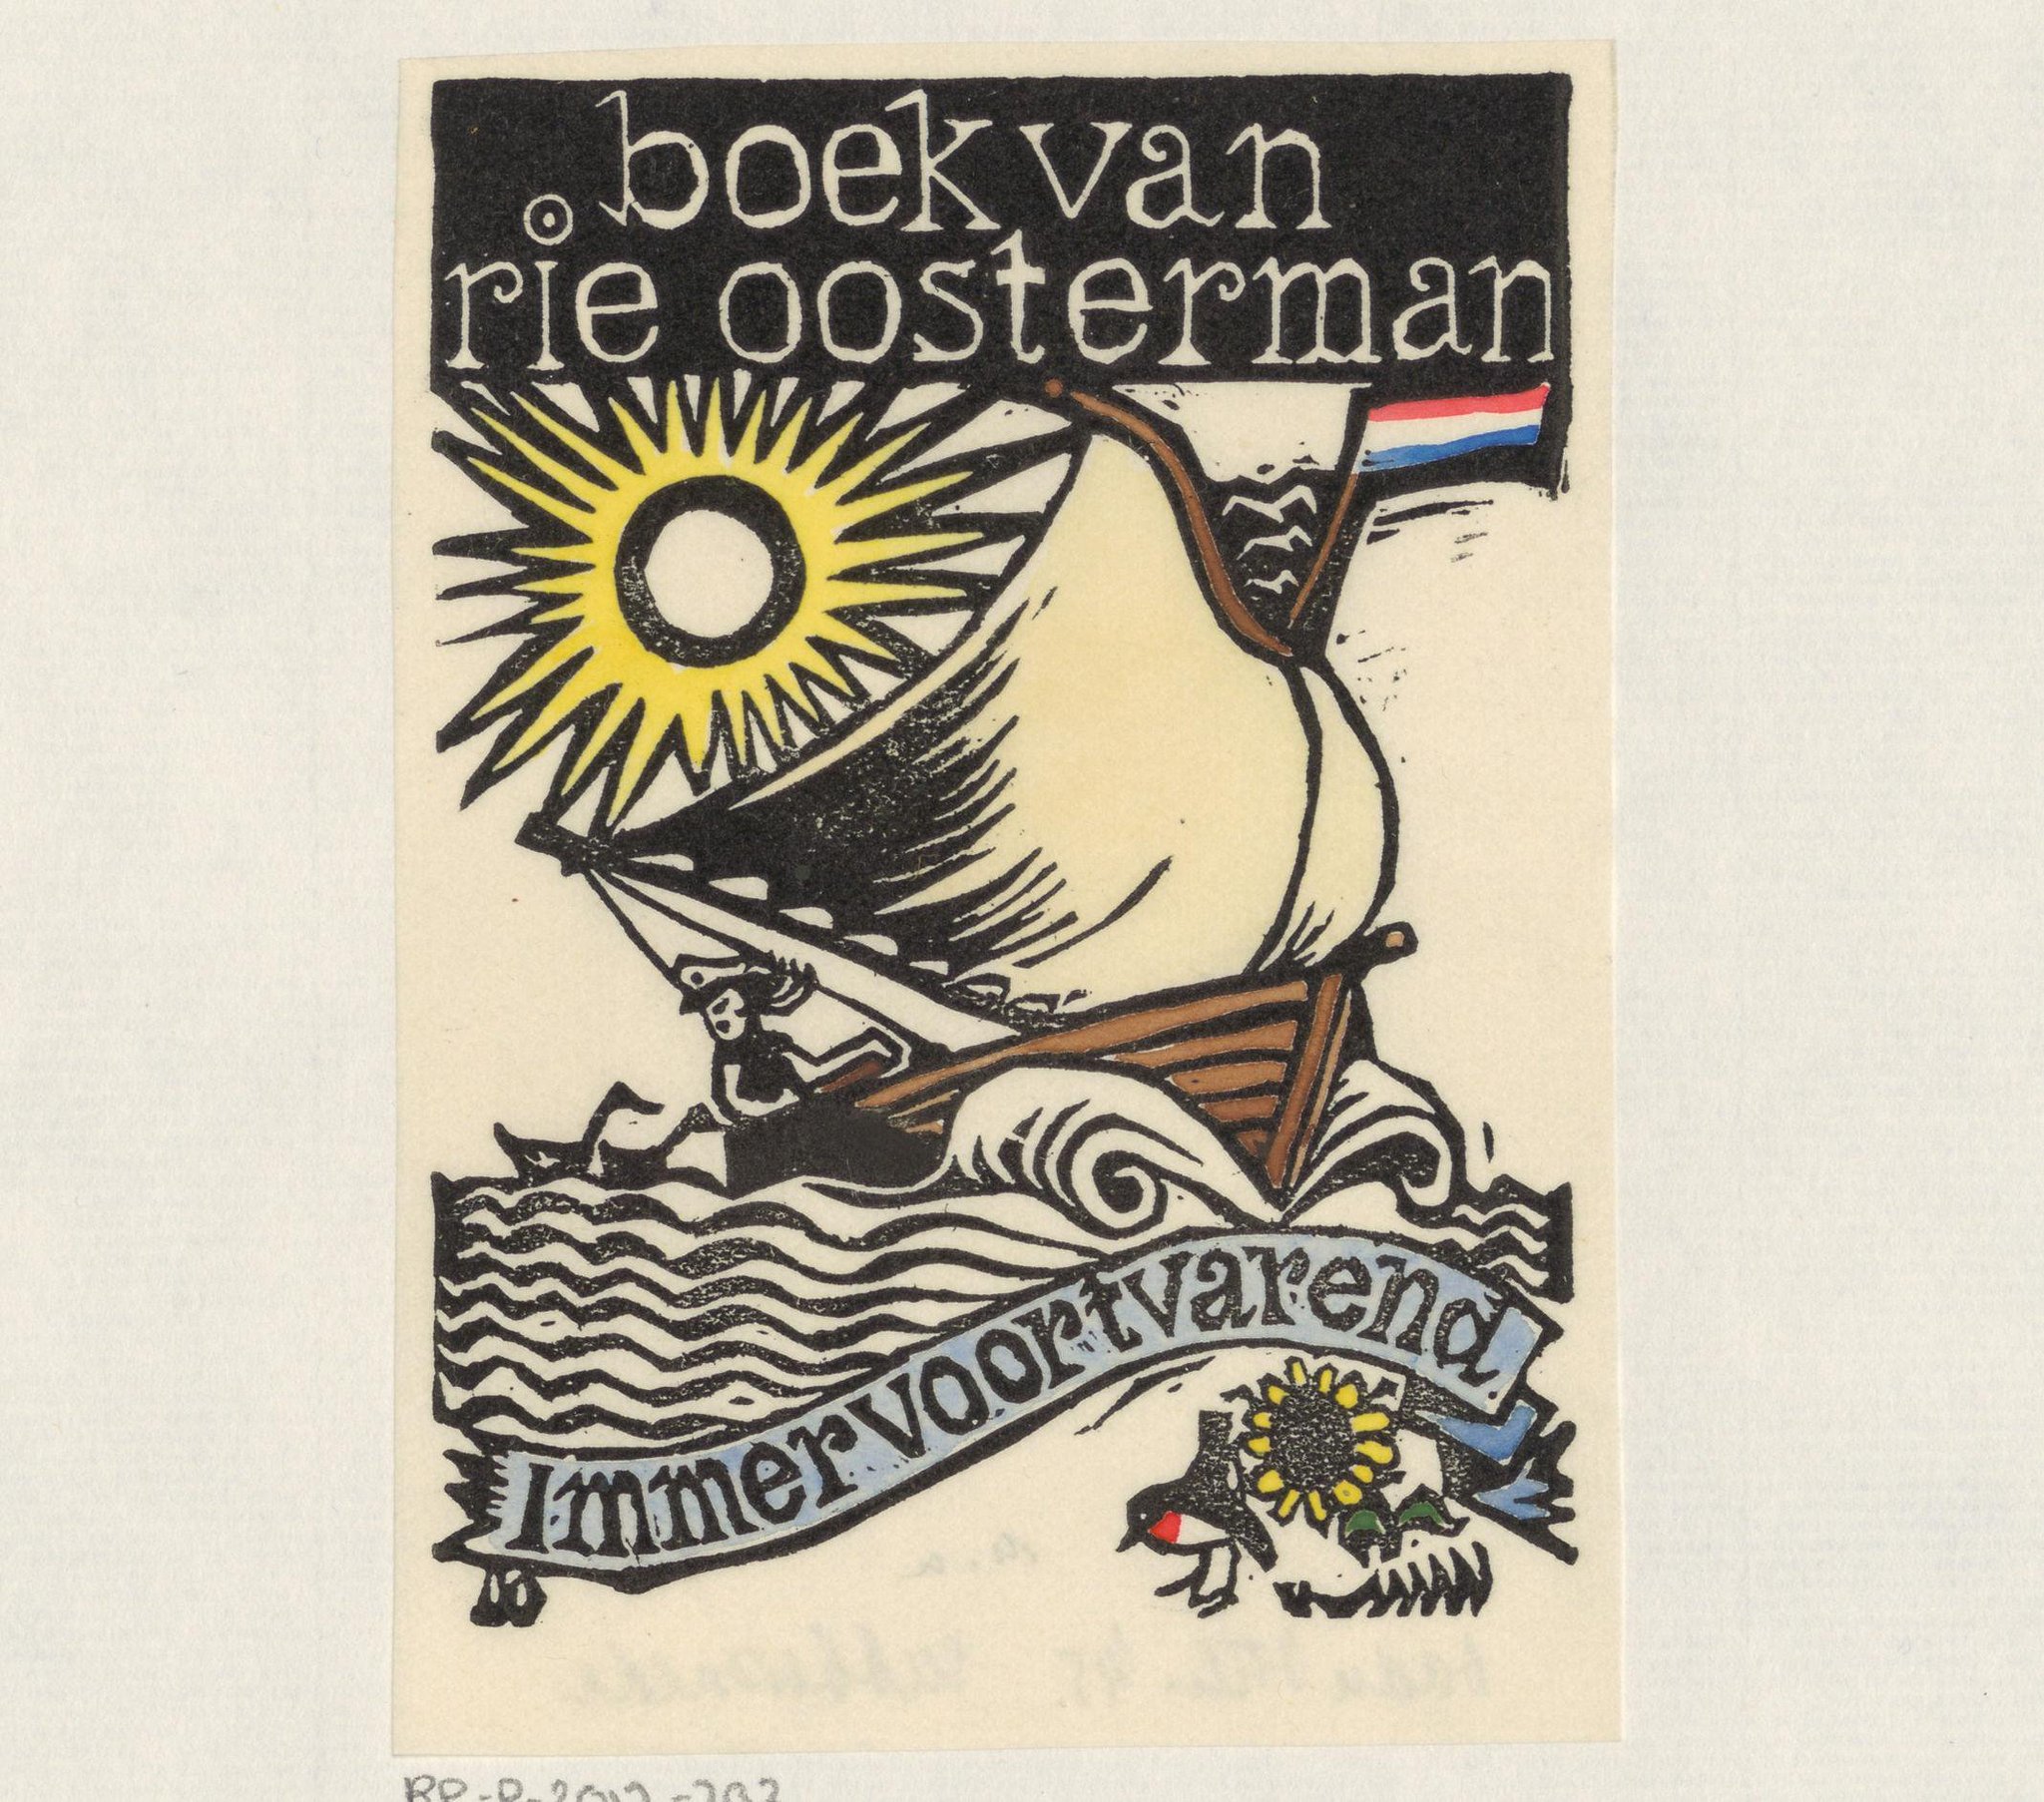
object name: bookplate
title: Immer voortvarend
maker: Anonymous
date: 1945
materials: paper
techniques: hand coloring, linocut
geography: netherlands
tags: sailing-ship, sailing-boat, sun as celestial body, flag, colours (as symbol of the state, etc.)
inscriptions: signature, date and inscription: ‘Dada Otten (?) '45 rubbersnede’